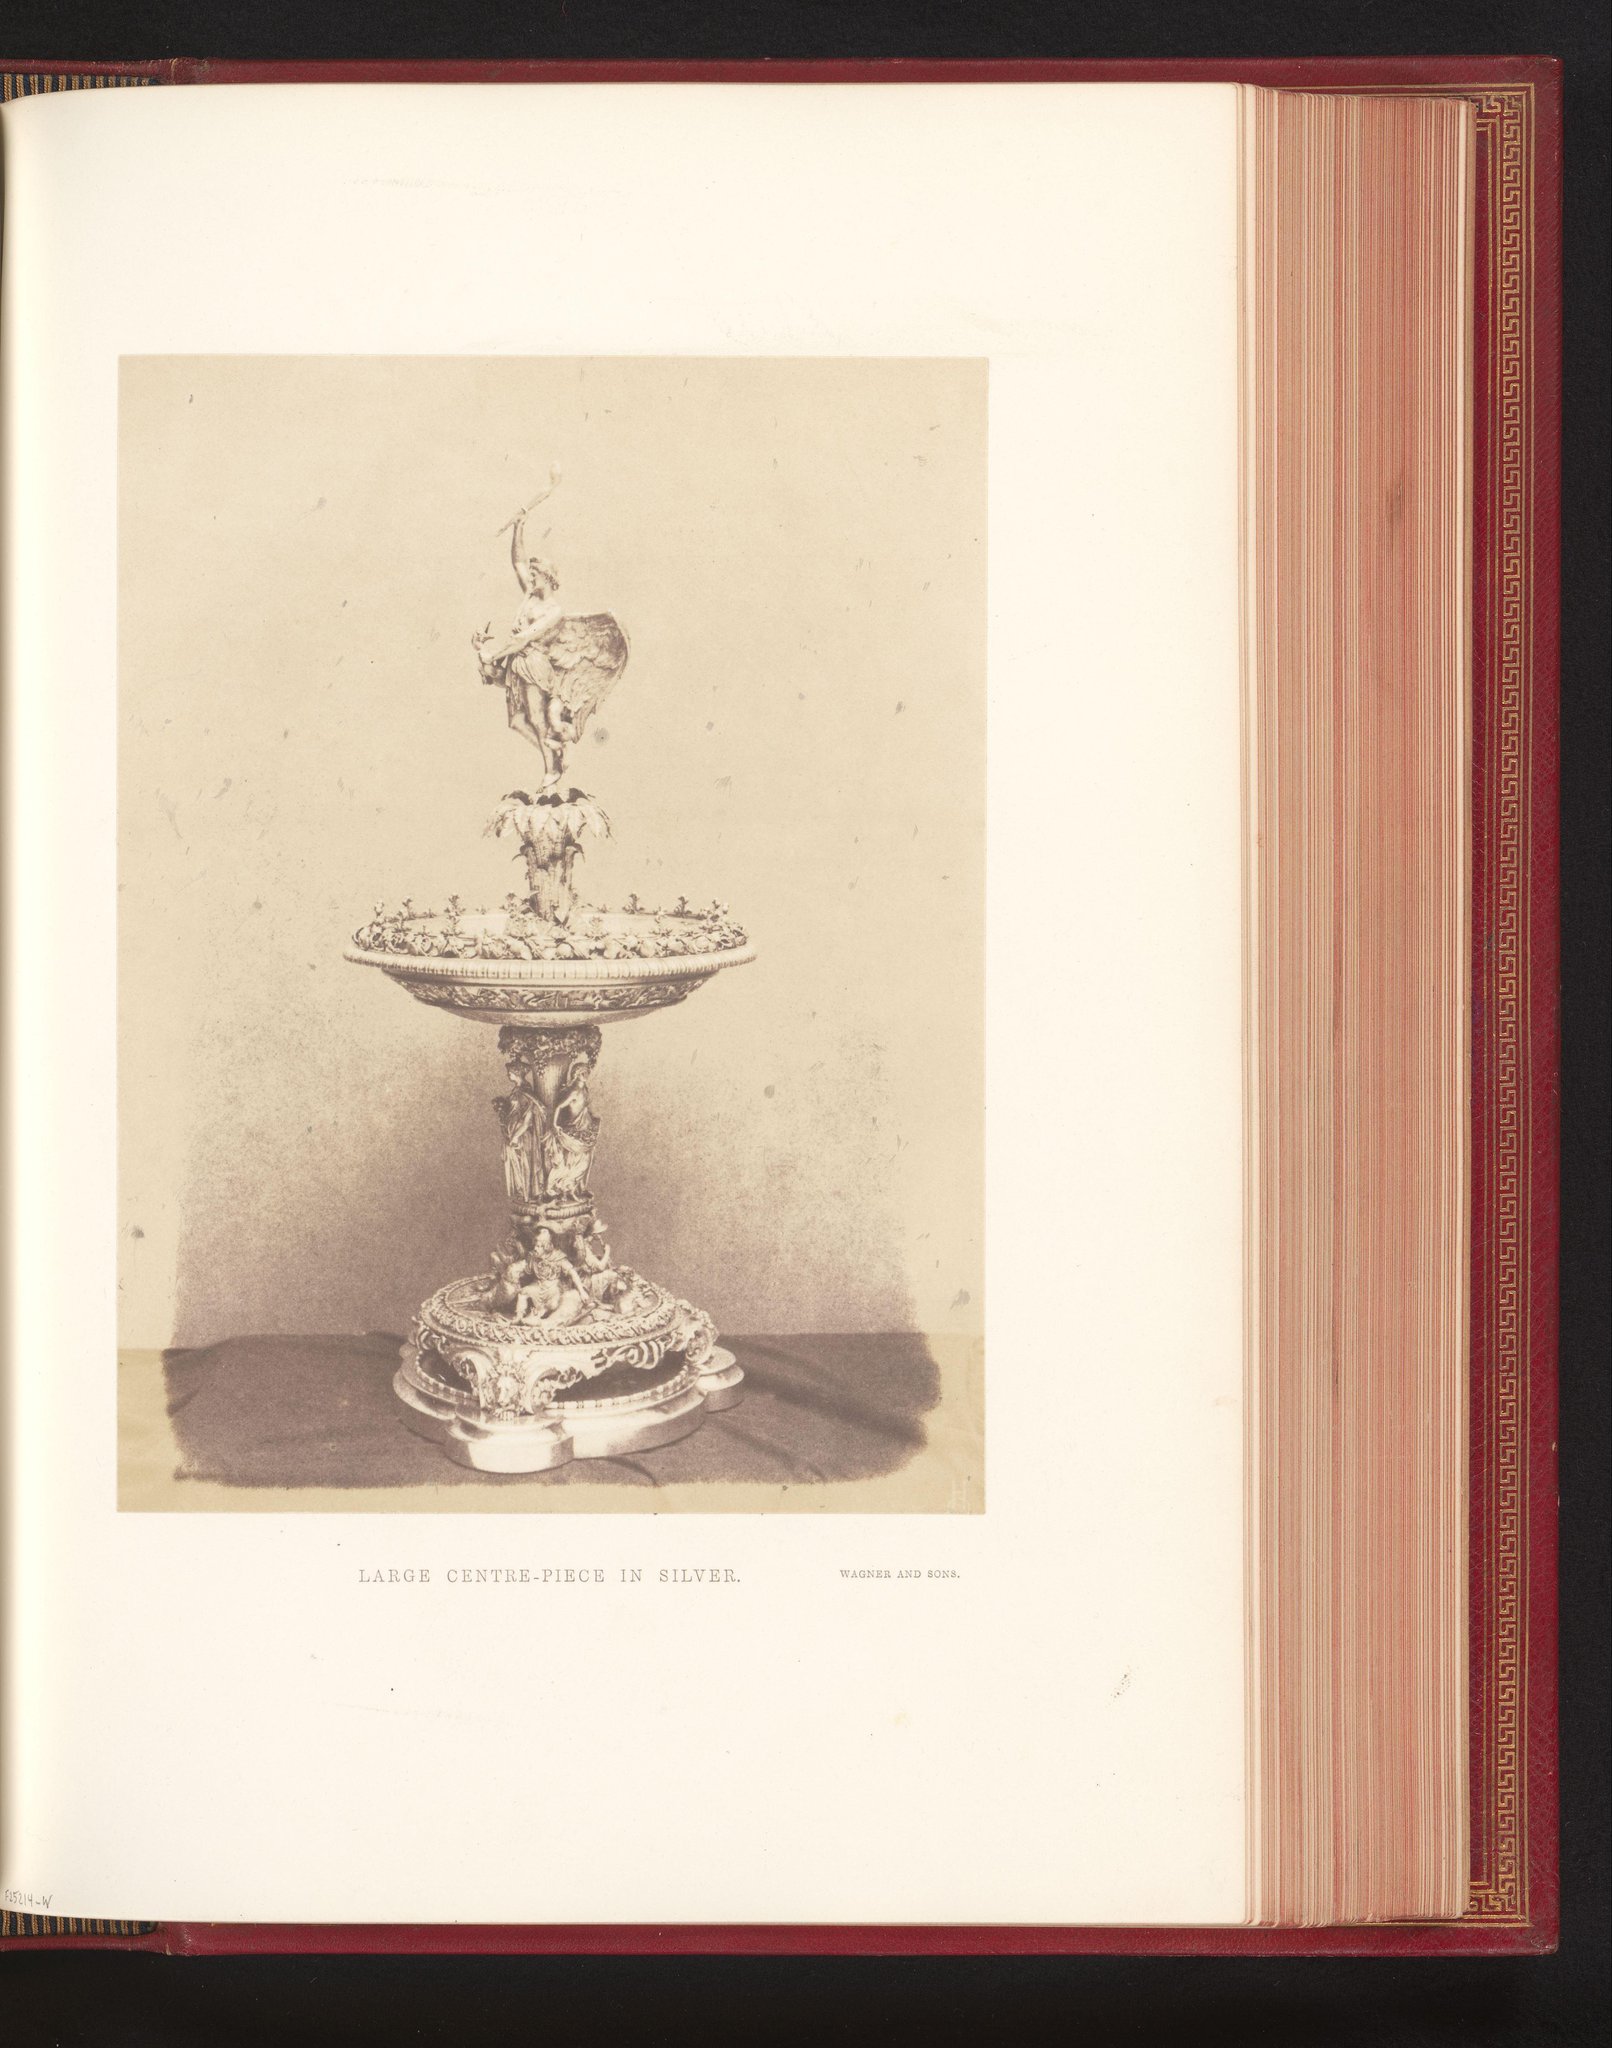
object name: photograph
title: Large Centre-Piece in Silver. Wagner and Sons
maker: hugh owen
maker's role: fotograaf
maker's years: 1808-1897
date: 1851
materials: photographic support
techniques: salted paper print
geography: london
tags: centre-piece, epergne, 'surtout', 'milieu-de-table', london